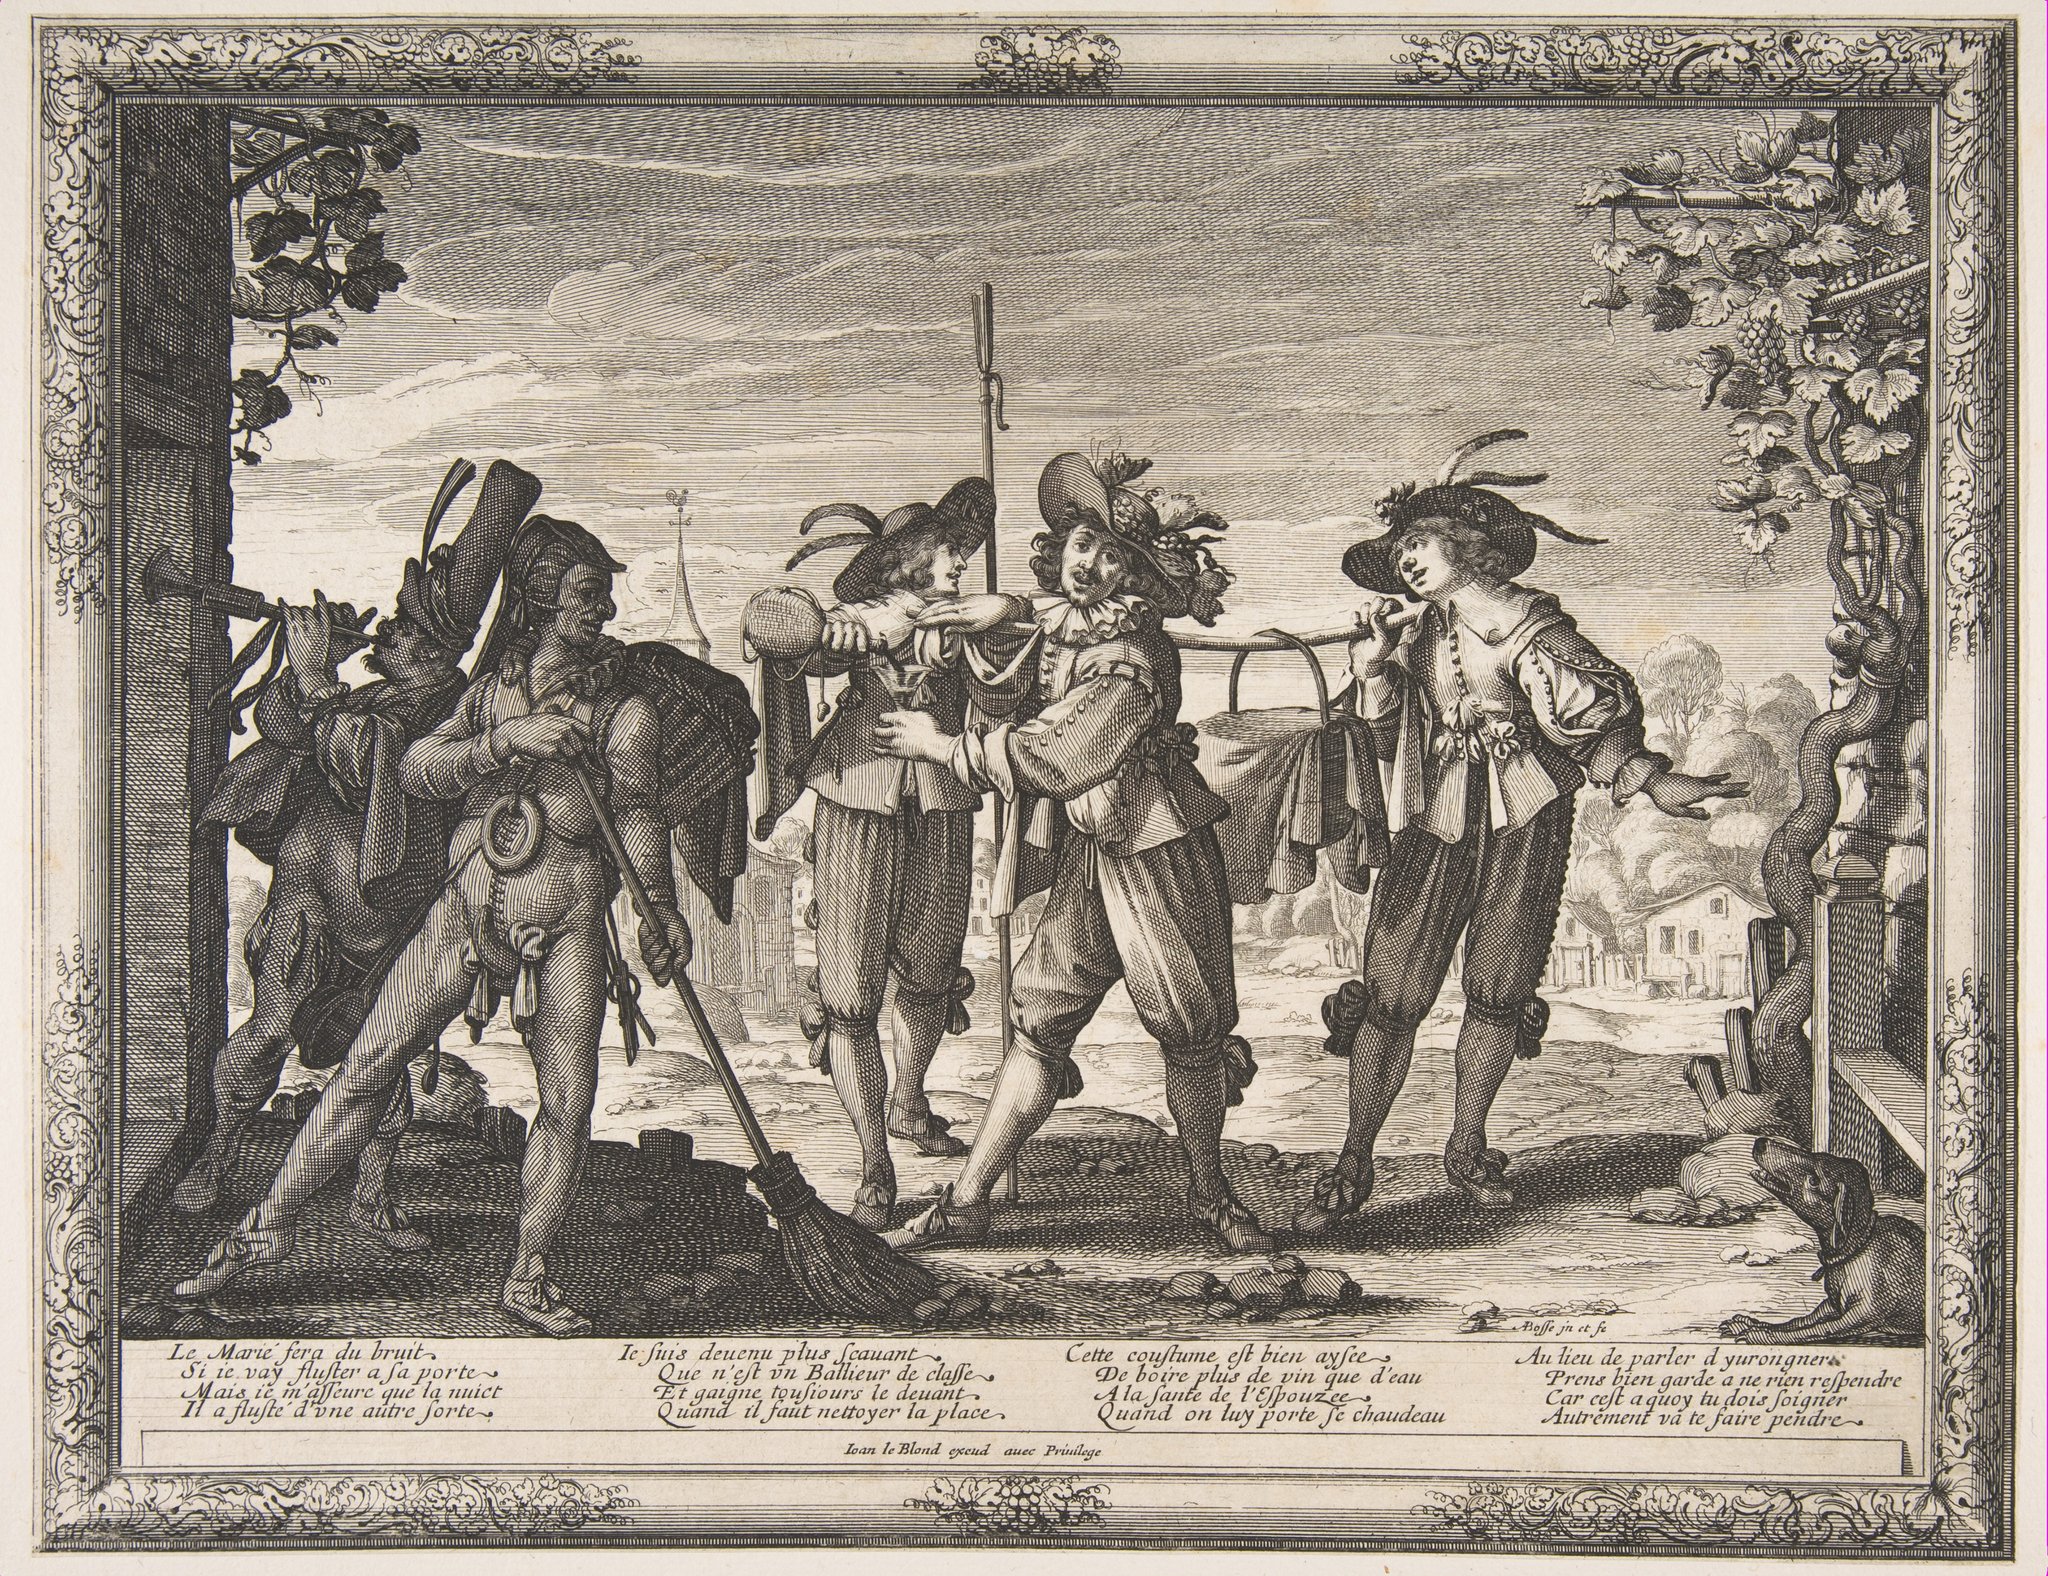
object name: print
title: Charivari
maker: abraham bosse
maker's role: artist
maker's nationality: french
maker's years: 1602-1676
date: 1633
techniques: engraving, etching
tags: musical instruments,men